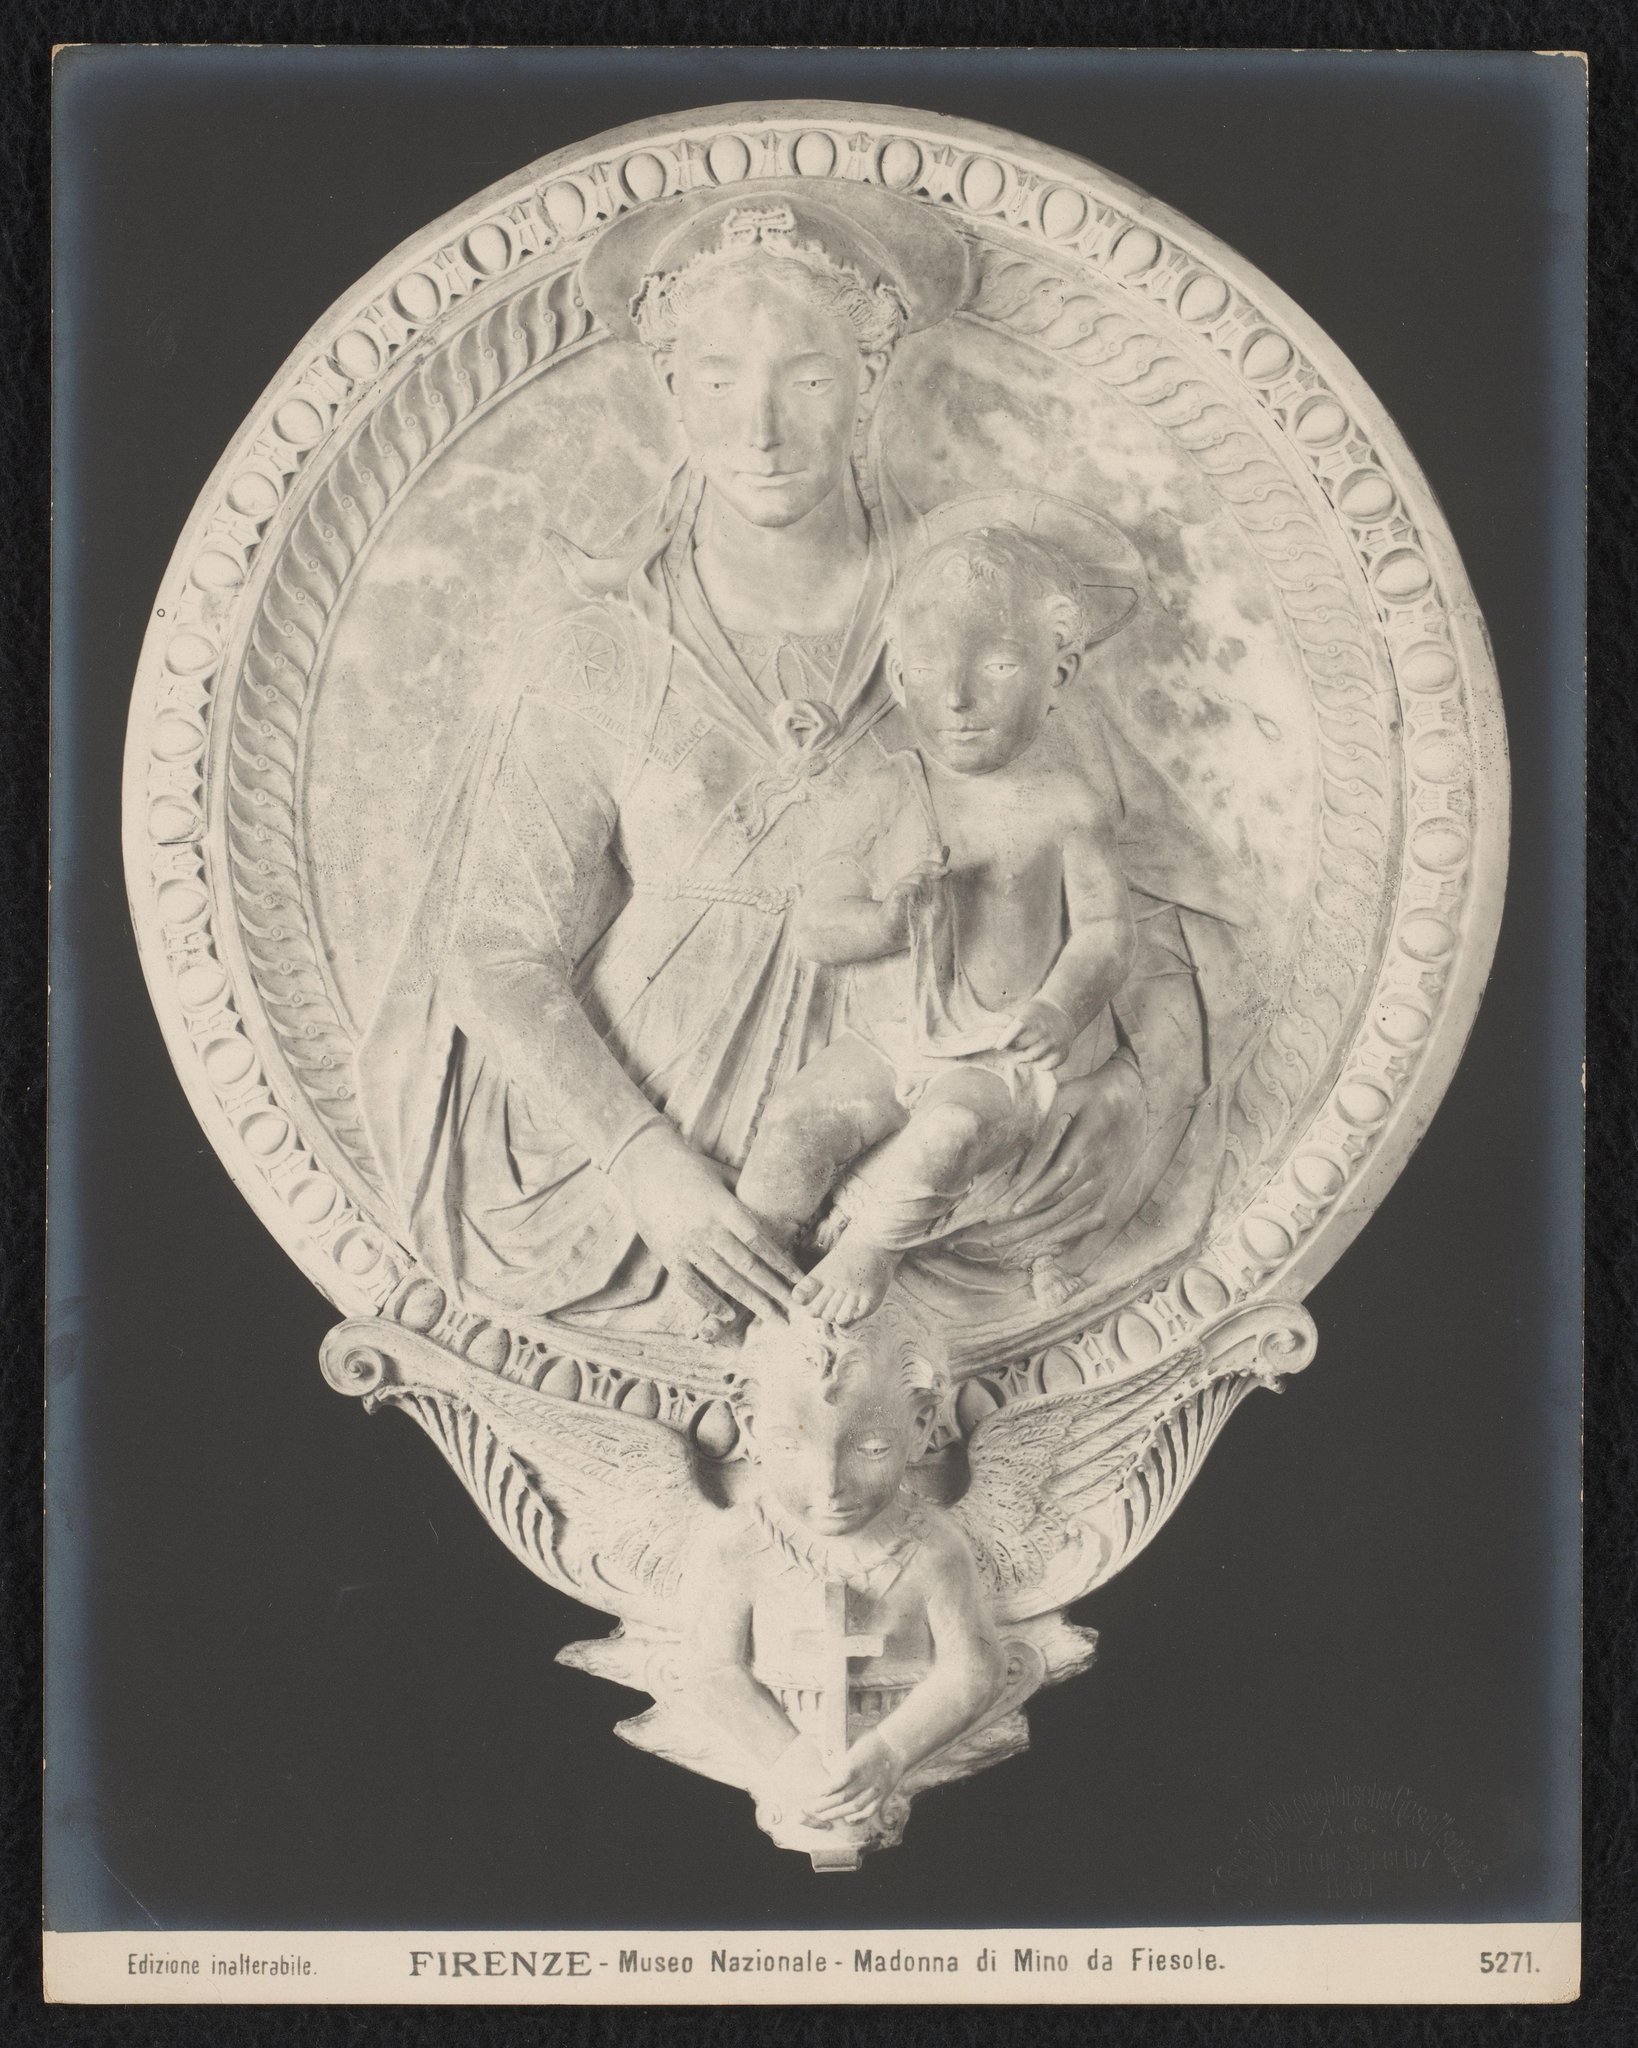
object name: photograph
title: Firenze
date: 1901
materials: paper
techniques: gelatin silver print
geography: florence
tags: madonna: i.e. mary with the christ-child, picture, painting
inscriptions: number: ‘5271.’, collector's mark: ‘RIJKS SCHOOL VOOR KUNSTNIJVERHEID/ GROEP’, inscription: ‘Edizione inalterabile.’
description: Deze foto maakt deel uit van een omslag.